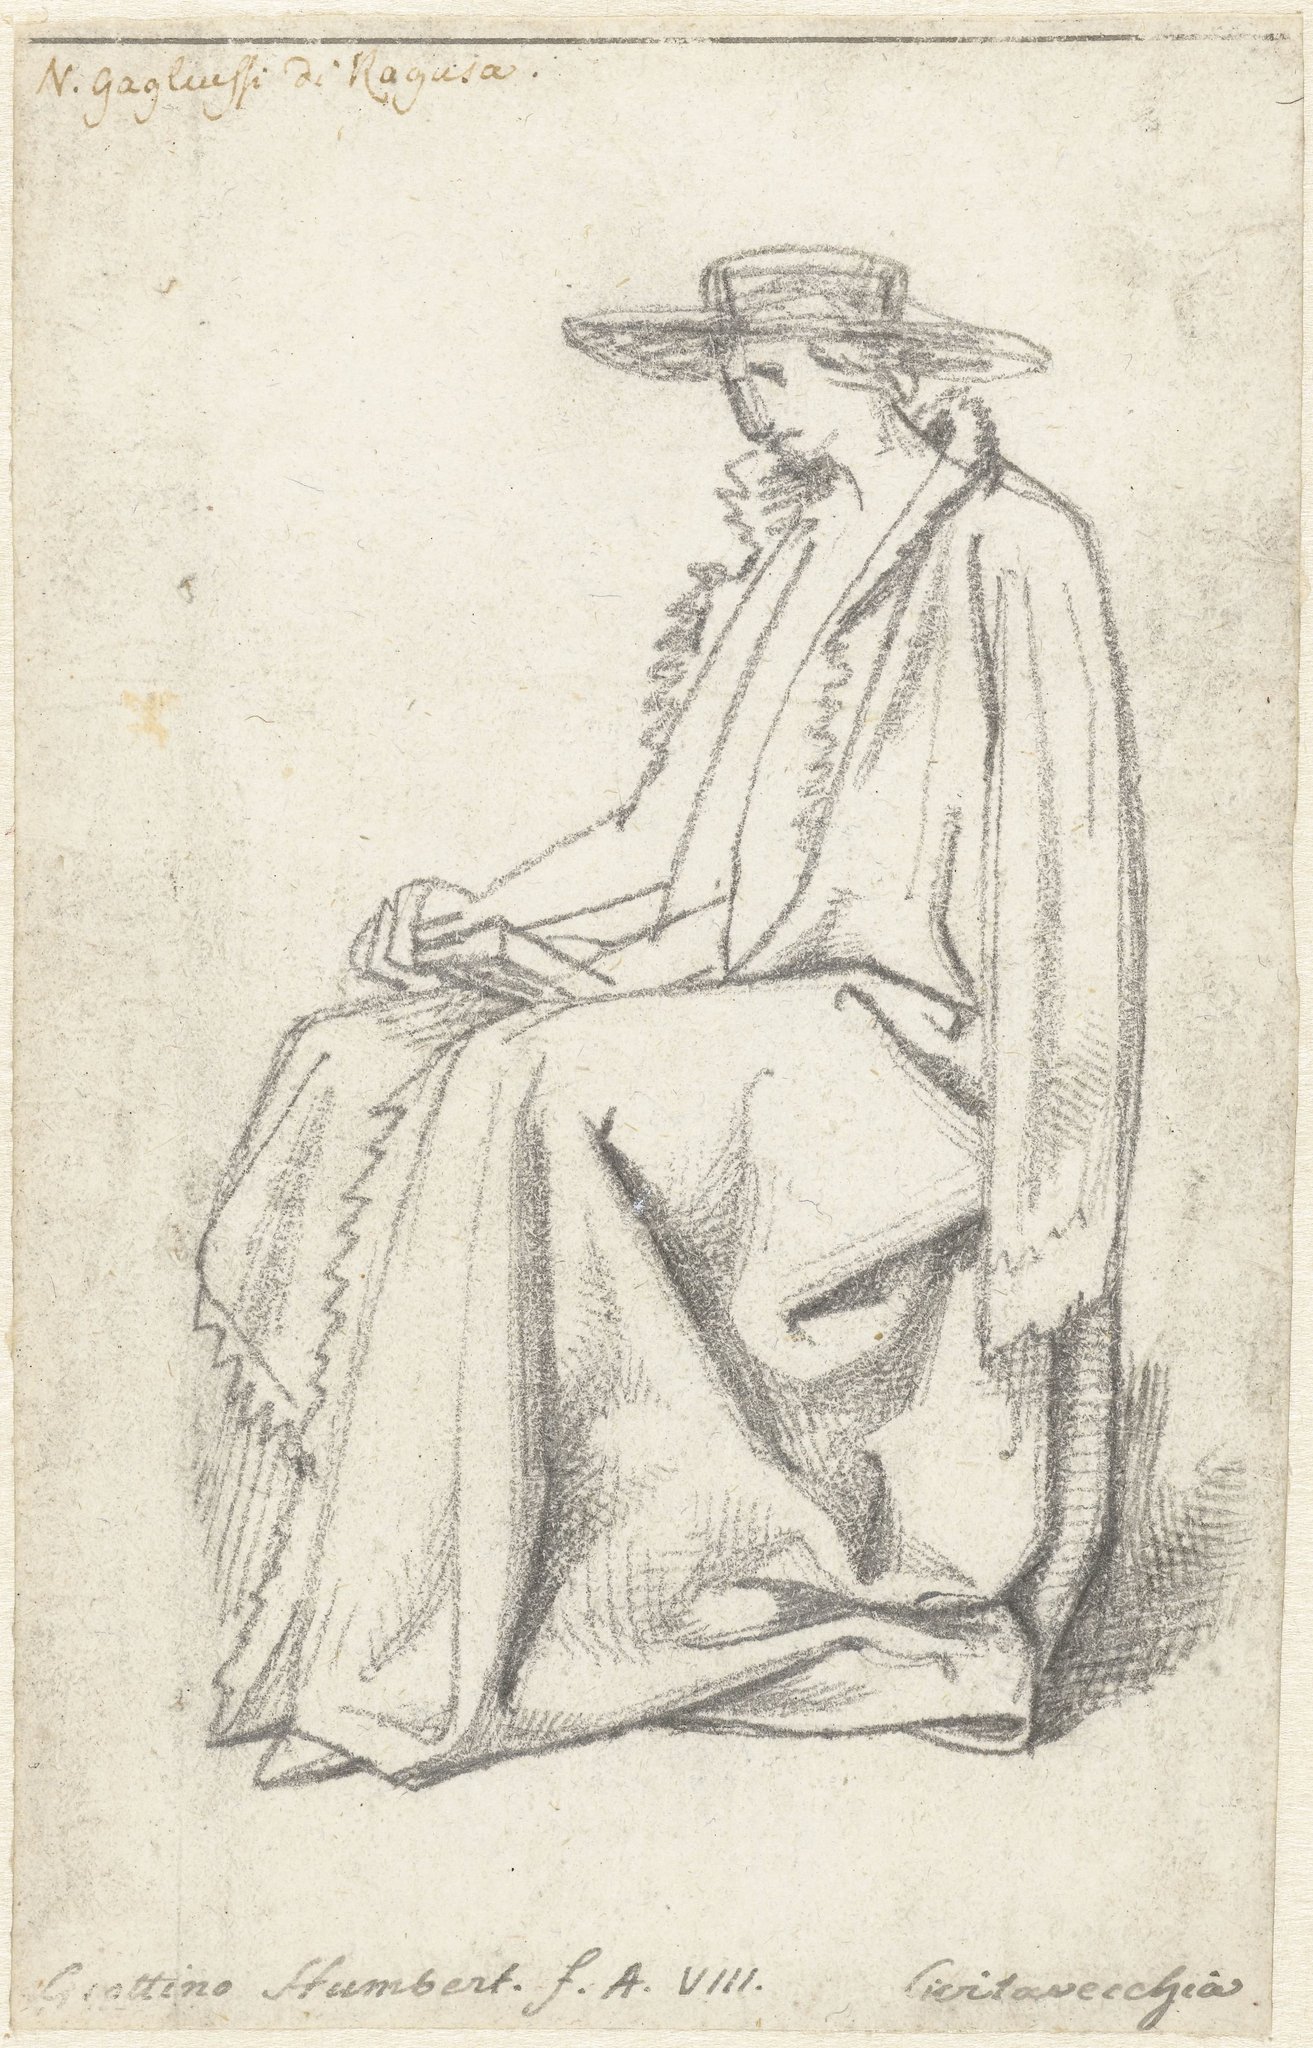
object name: drawing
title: Zittende, lezende man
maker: david pièrre giottino humbert de superville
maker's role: draughtsman, painter, print maker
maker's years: 1770-1849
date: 1780-1849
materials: paper, pencil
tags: reading